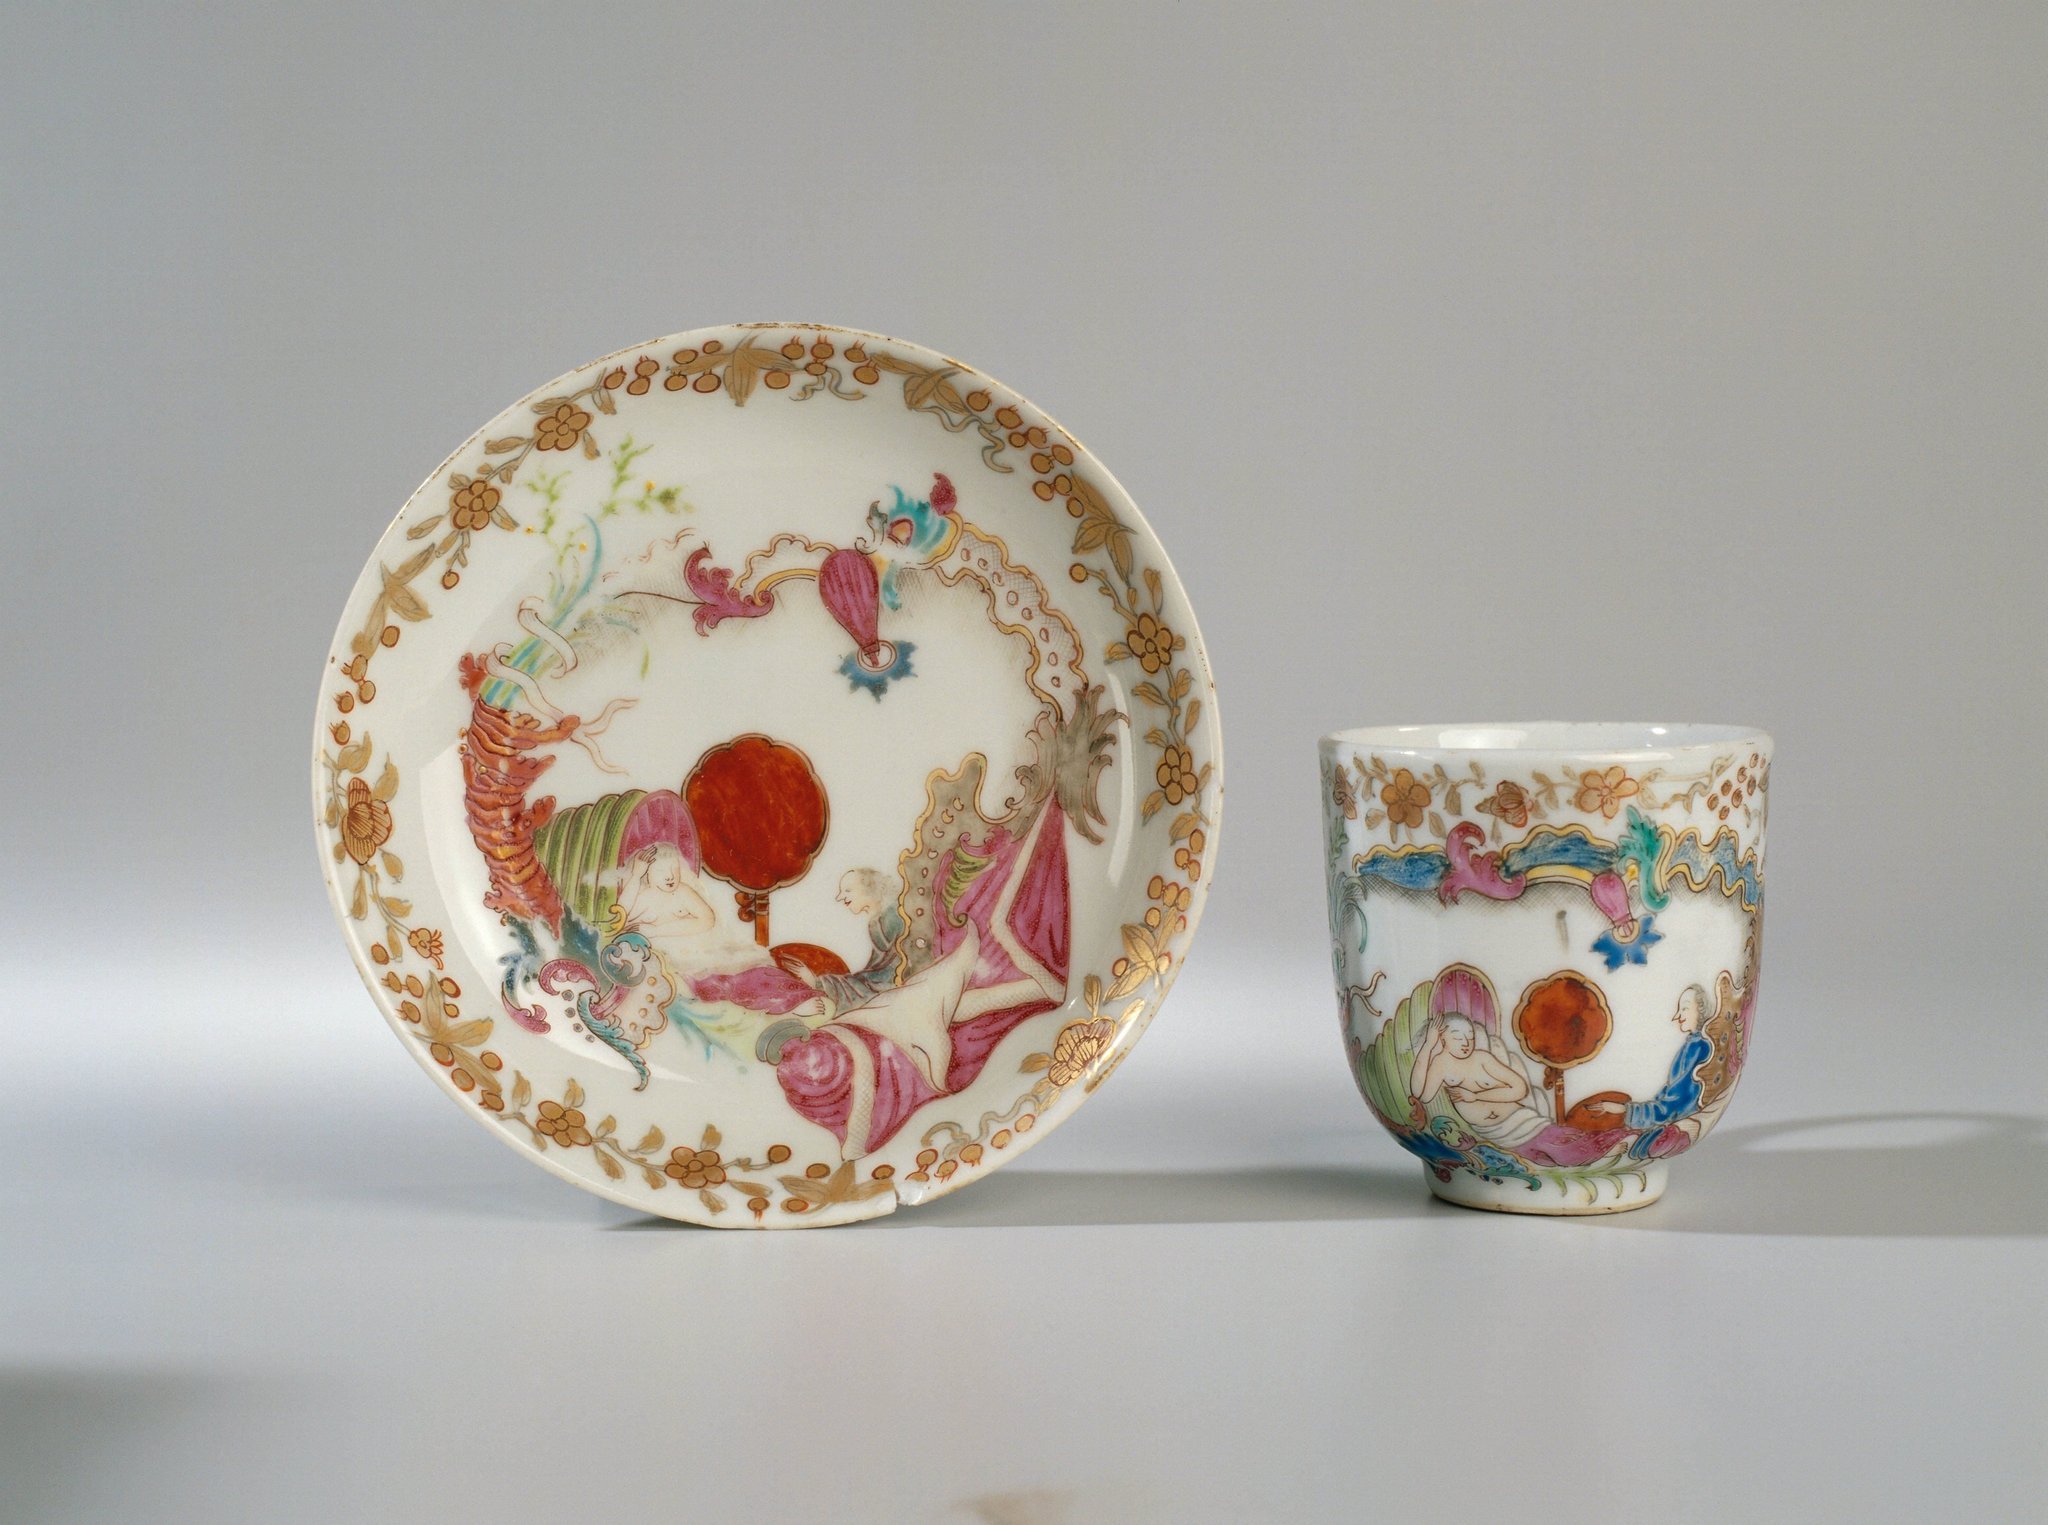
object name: kop en schotel, kop en schotel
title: Bell-shaped cup and saucer with an erotic scene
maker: Anonymous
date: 1745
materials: glaze, gold, paint, porcelain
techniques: firing, gilding, turning, vitrification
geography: china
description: Platte schotel op een voetring, gedecoreerd in emailkleuren. Zowel op de schotel als op de kop een voorstelling van een man en een half ontklede vrouw. Op het porselein is de letter A aangebracht. De randen van de kop en schotel zijn versierd met slingerende bloemtakken. Porselein met erotische scènes zoals deze vormen een aparte subgroep binnen het Deze kunnen variëren van zeer pornografisch tot milde erotische weergaven van klassieke mythologische liefdesverhalen. Mogelijk wijst de letter A erop dat dit porselein bestemd was voor een bepaalde persoon.